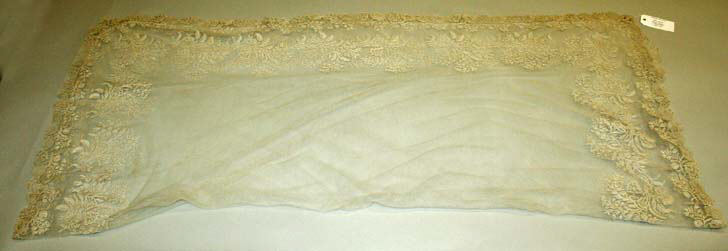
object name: scarf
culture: belgian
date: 1801-1825